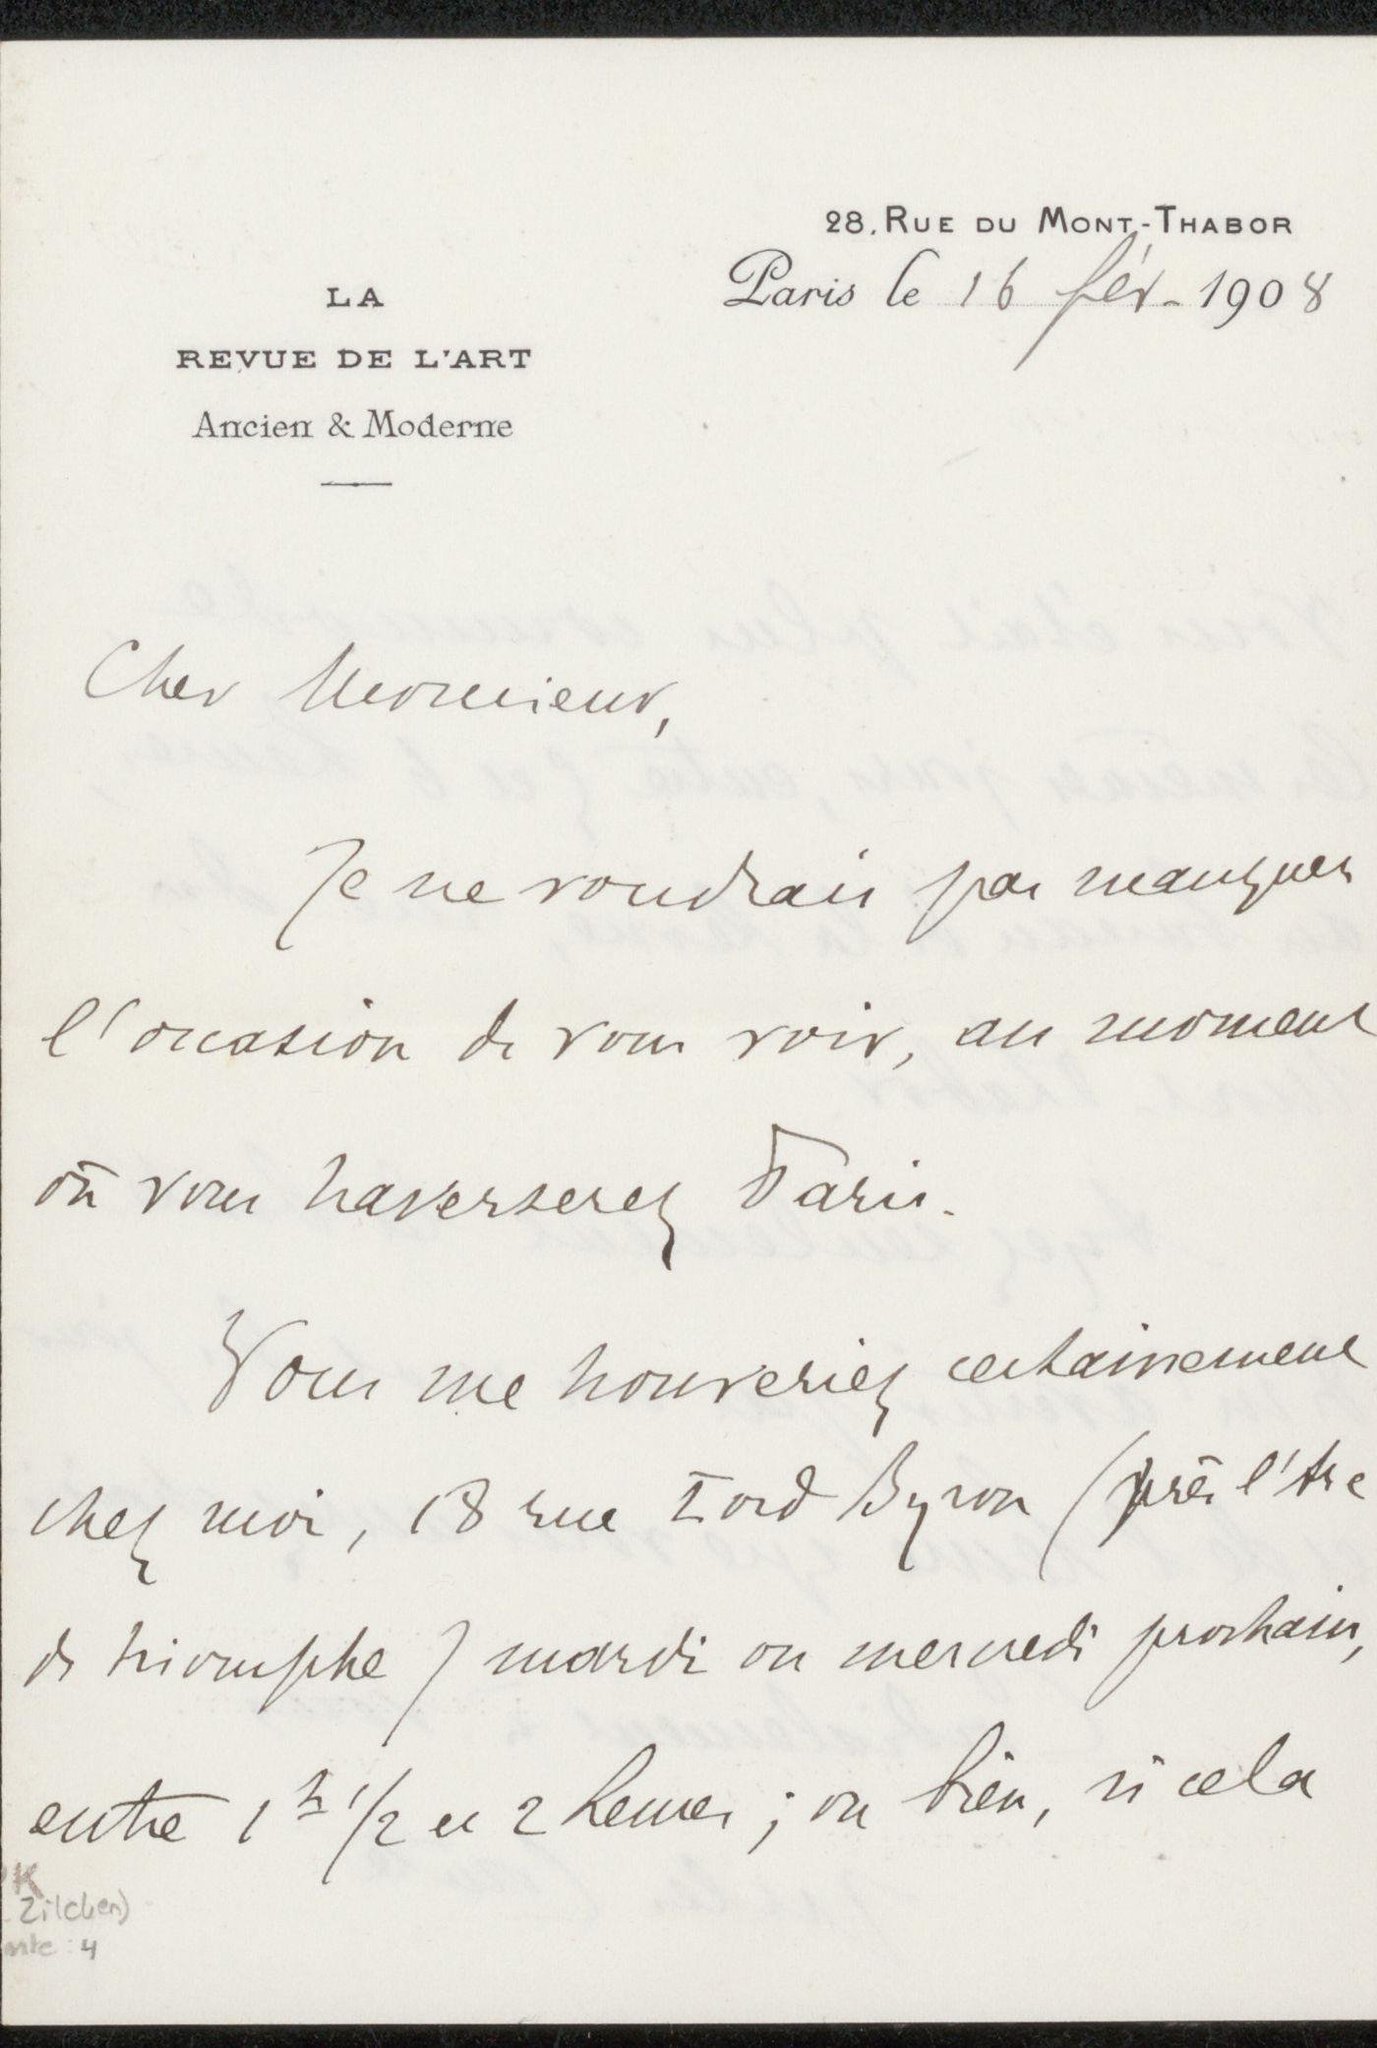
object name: letter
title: Brief aan Philip Zilcken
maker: jules comte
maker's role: official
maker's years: 1846-1912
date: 1908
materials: ink, paper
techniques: pen, printing, writing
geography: paris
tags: the hague, painter, draughtsman, philip zilcken, paris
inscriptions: collector's mark: ‘RPK’, watermark